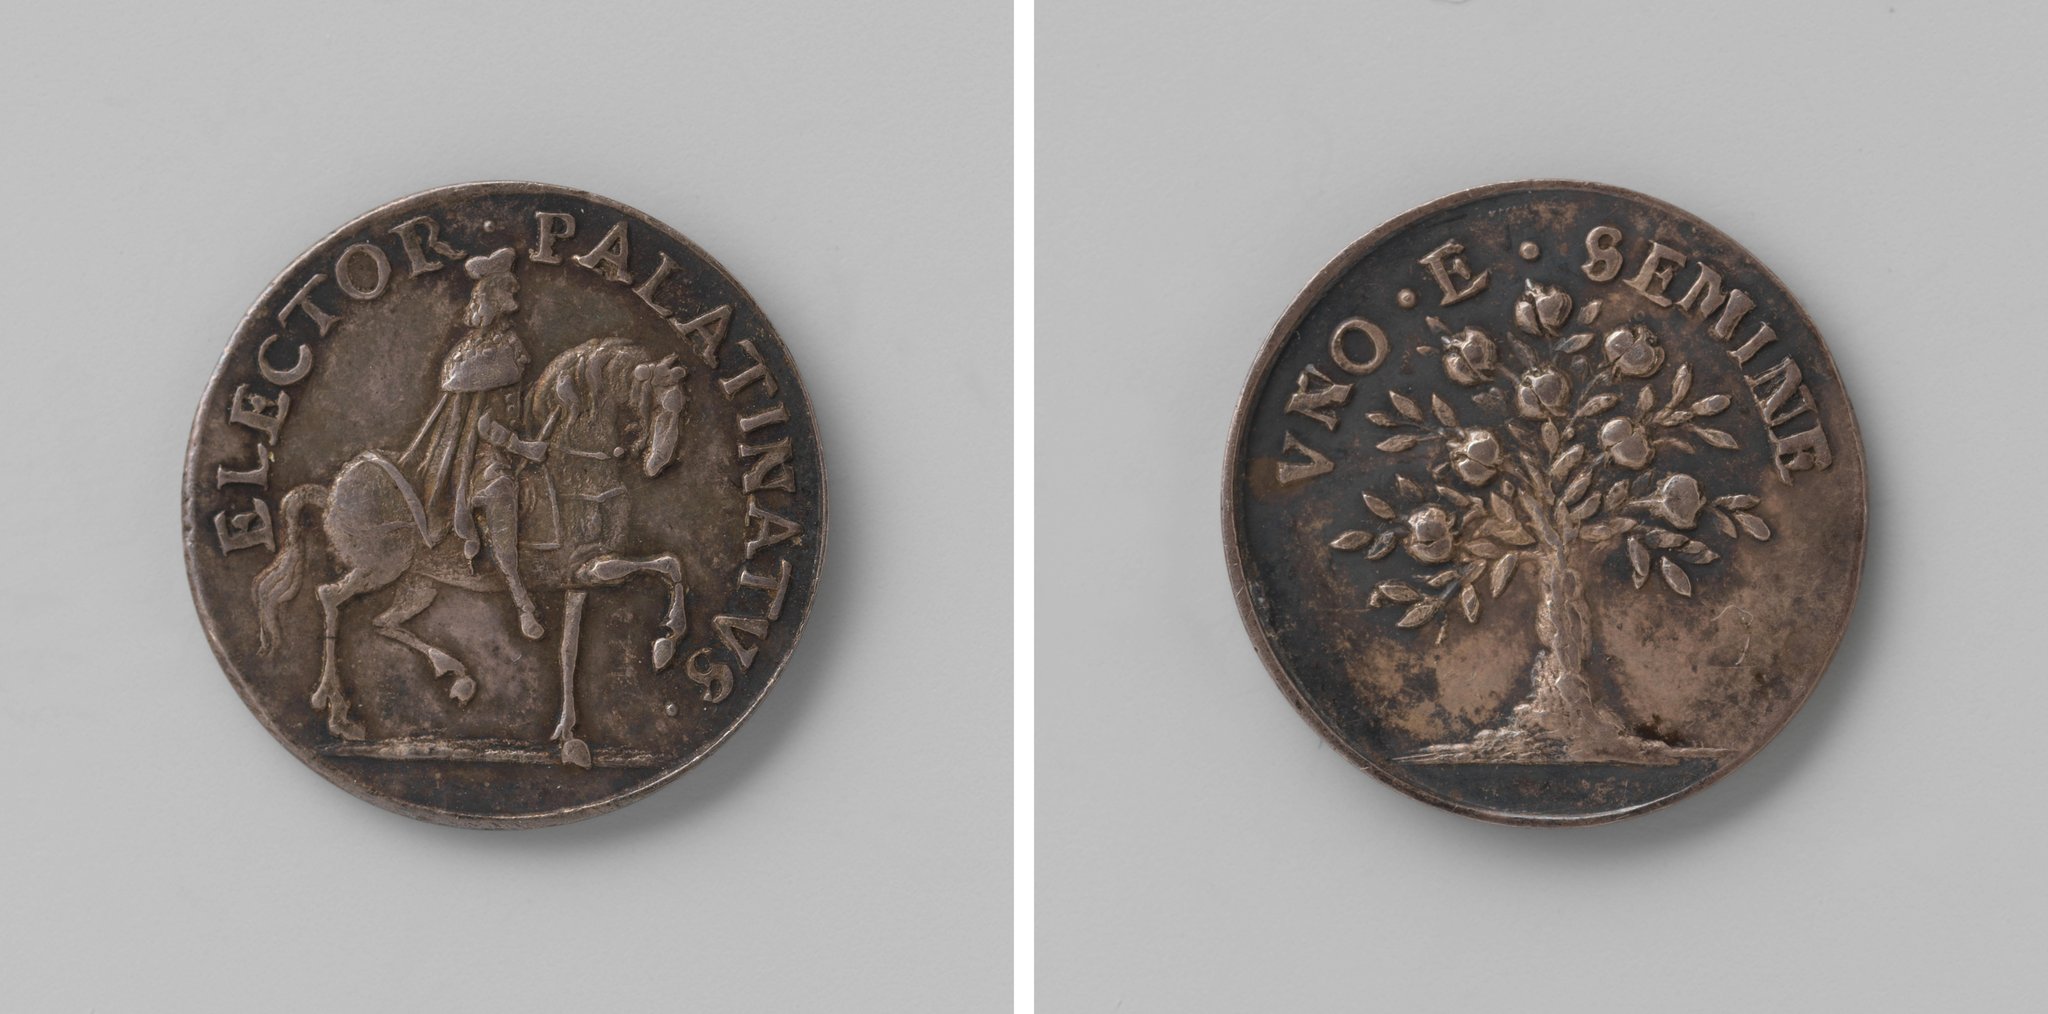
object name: strooipenning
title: Maximiliaan Emanuel, keurvorst van de Palts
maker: Anonymous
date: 1690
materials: silver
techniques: striking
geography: germany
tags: maximiliaan ii emanuel (keurvorst van beieren)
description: Zilveren penning. Voorzijde: man te paard binnen omschrift. Keerzijde: boom met vruchten binnen omschrift